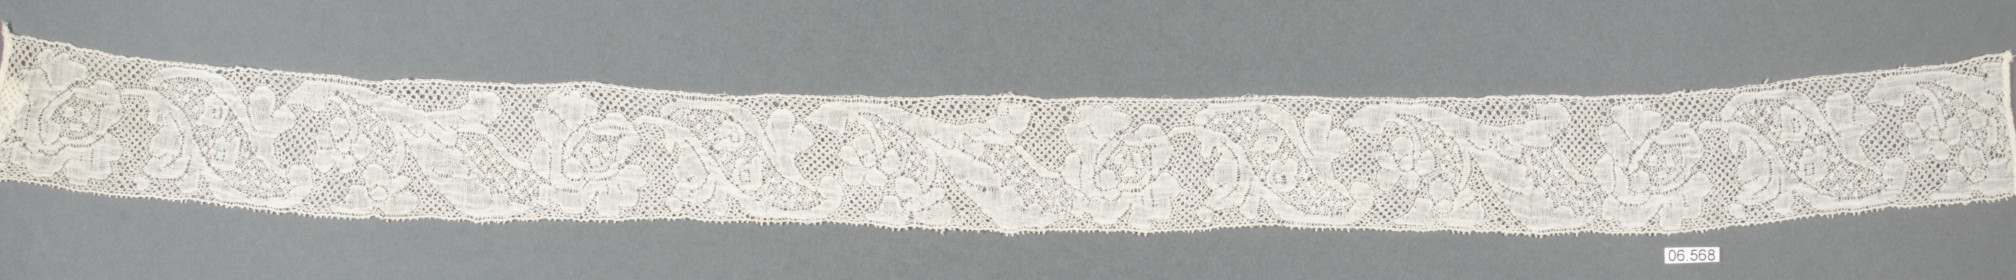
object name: strip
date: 1701-1800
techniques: lace